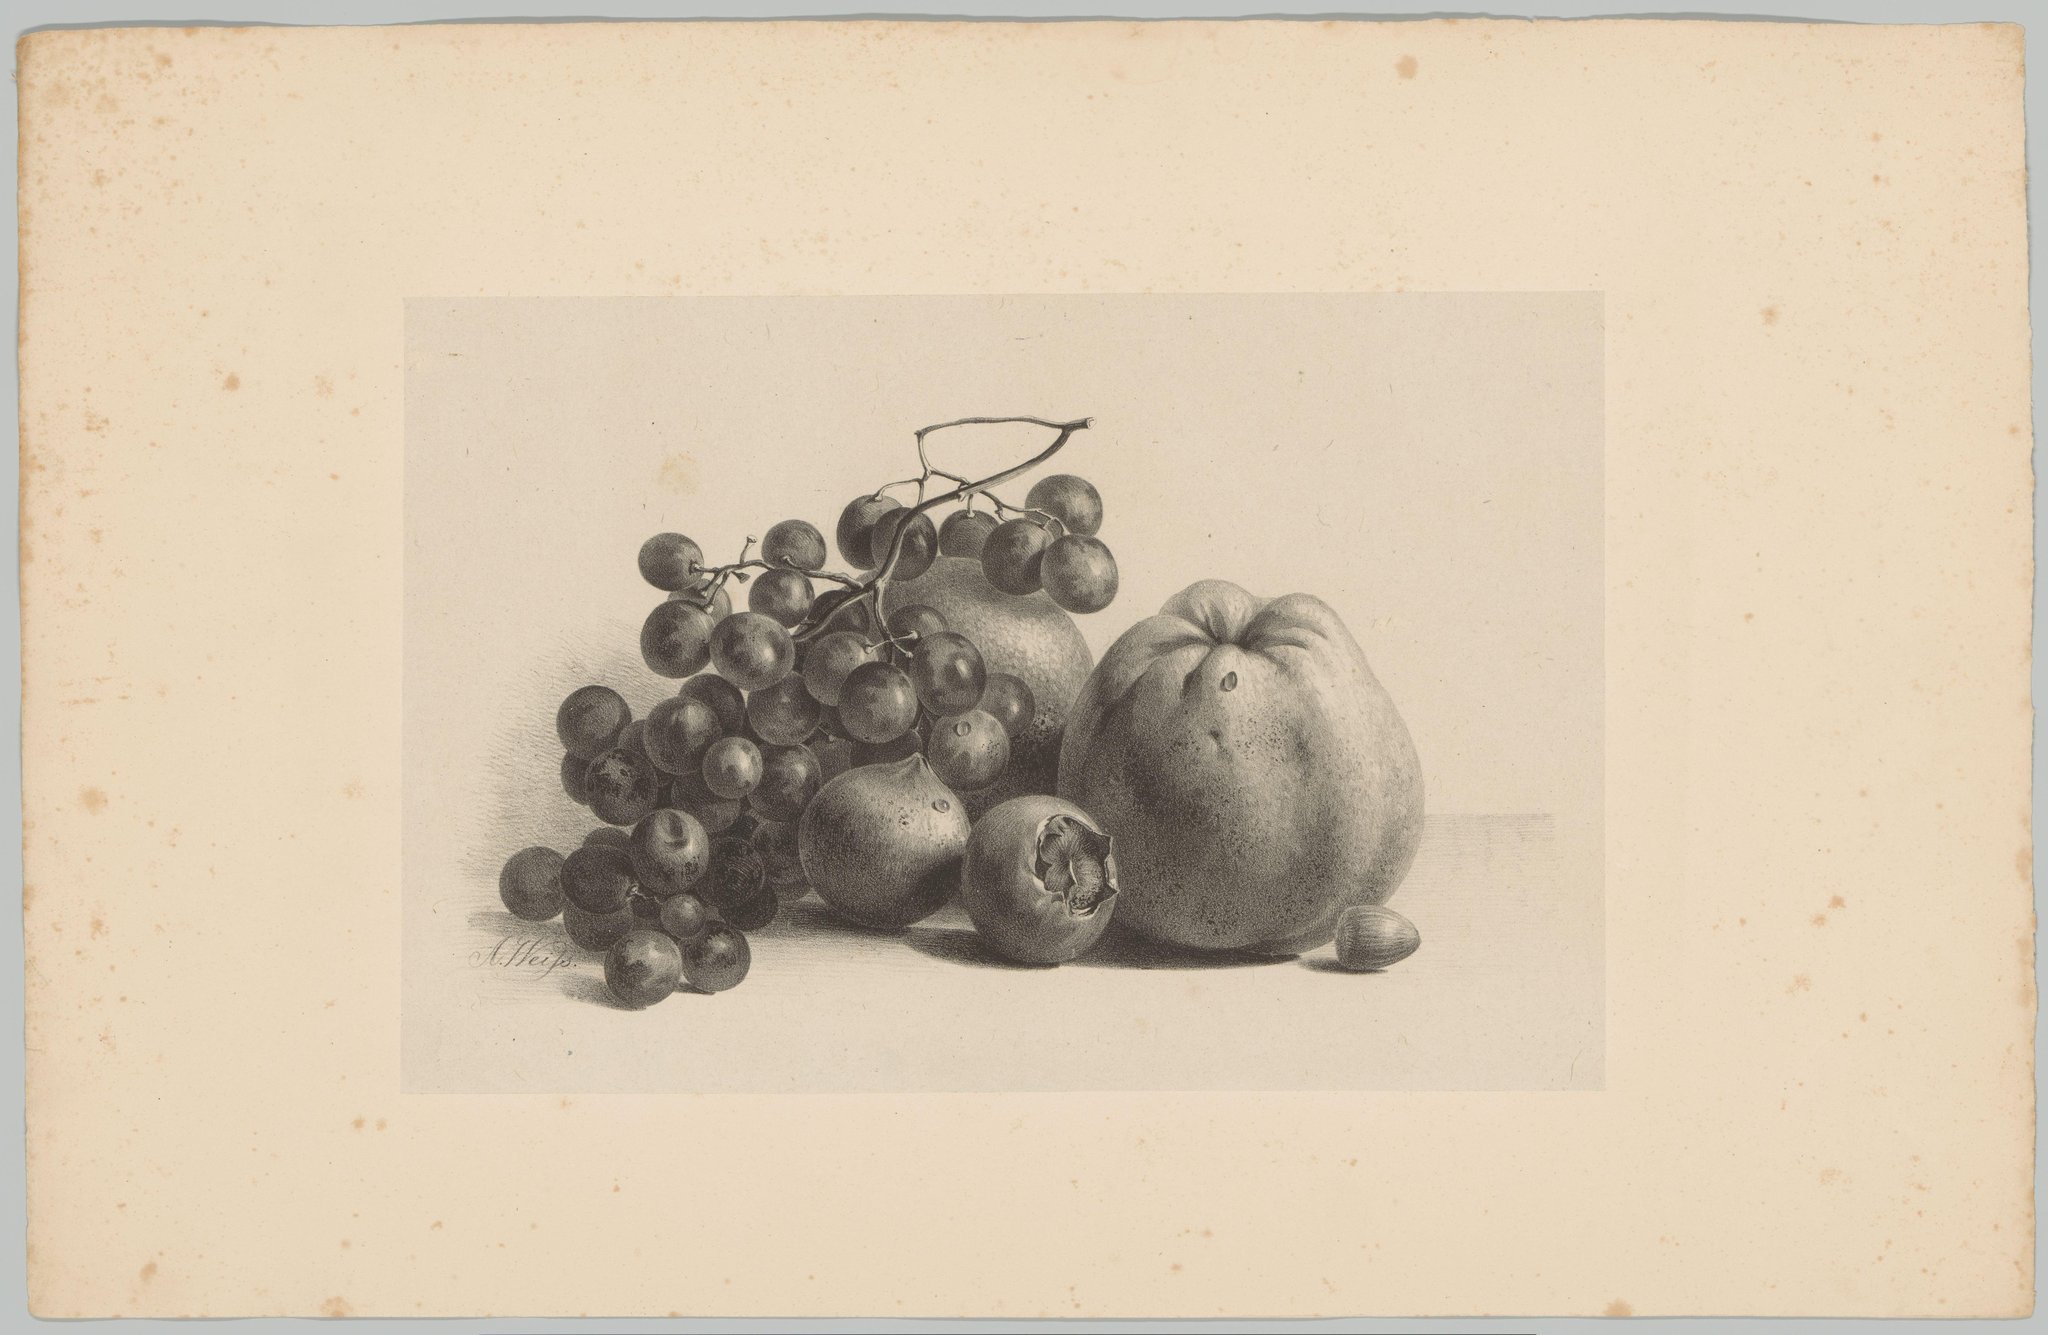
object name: print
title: Bloem en Fruit Studien (...) 3de aflevering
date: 1820-1833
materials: paper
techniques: lithograph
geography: amsterdam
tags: fruits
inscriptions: collector's mark: Lugt 2228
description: Onderdeel van een omslag met in totaal zevenenzeventig lithografieën van bloemen en fruit.